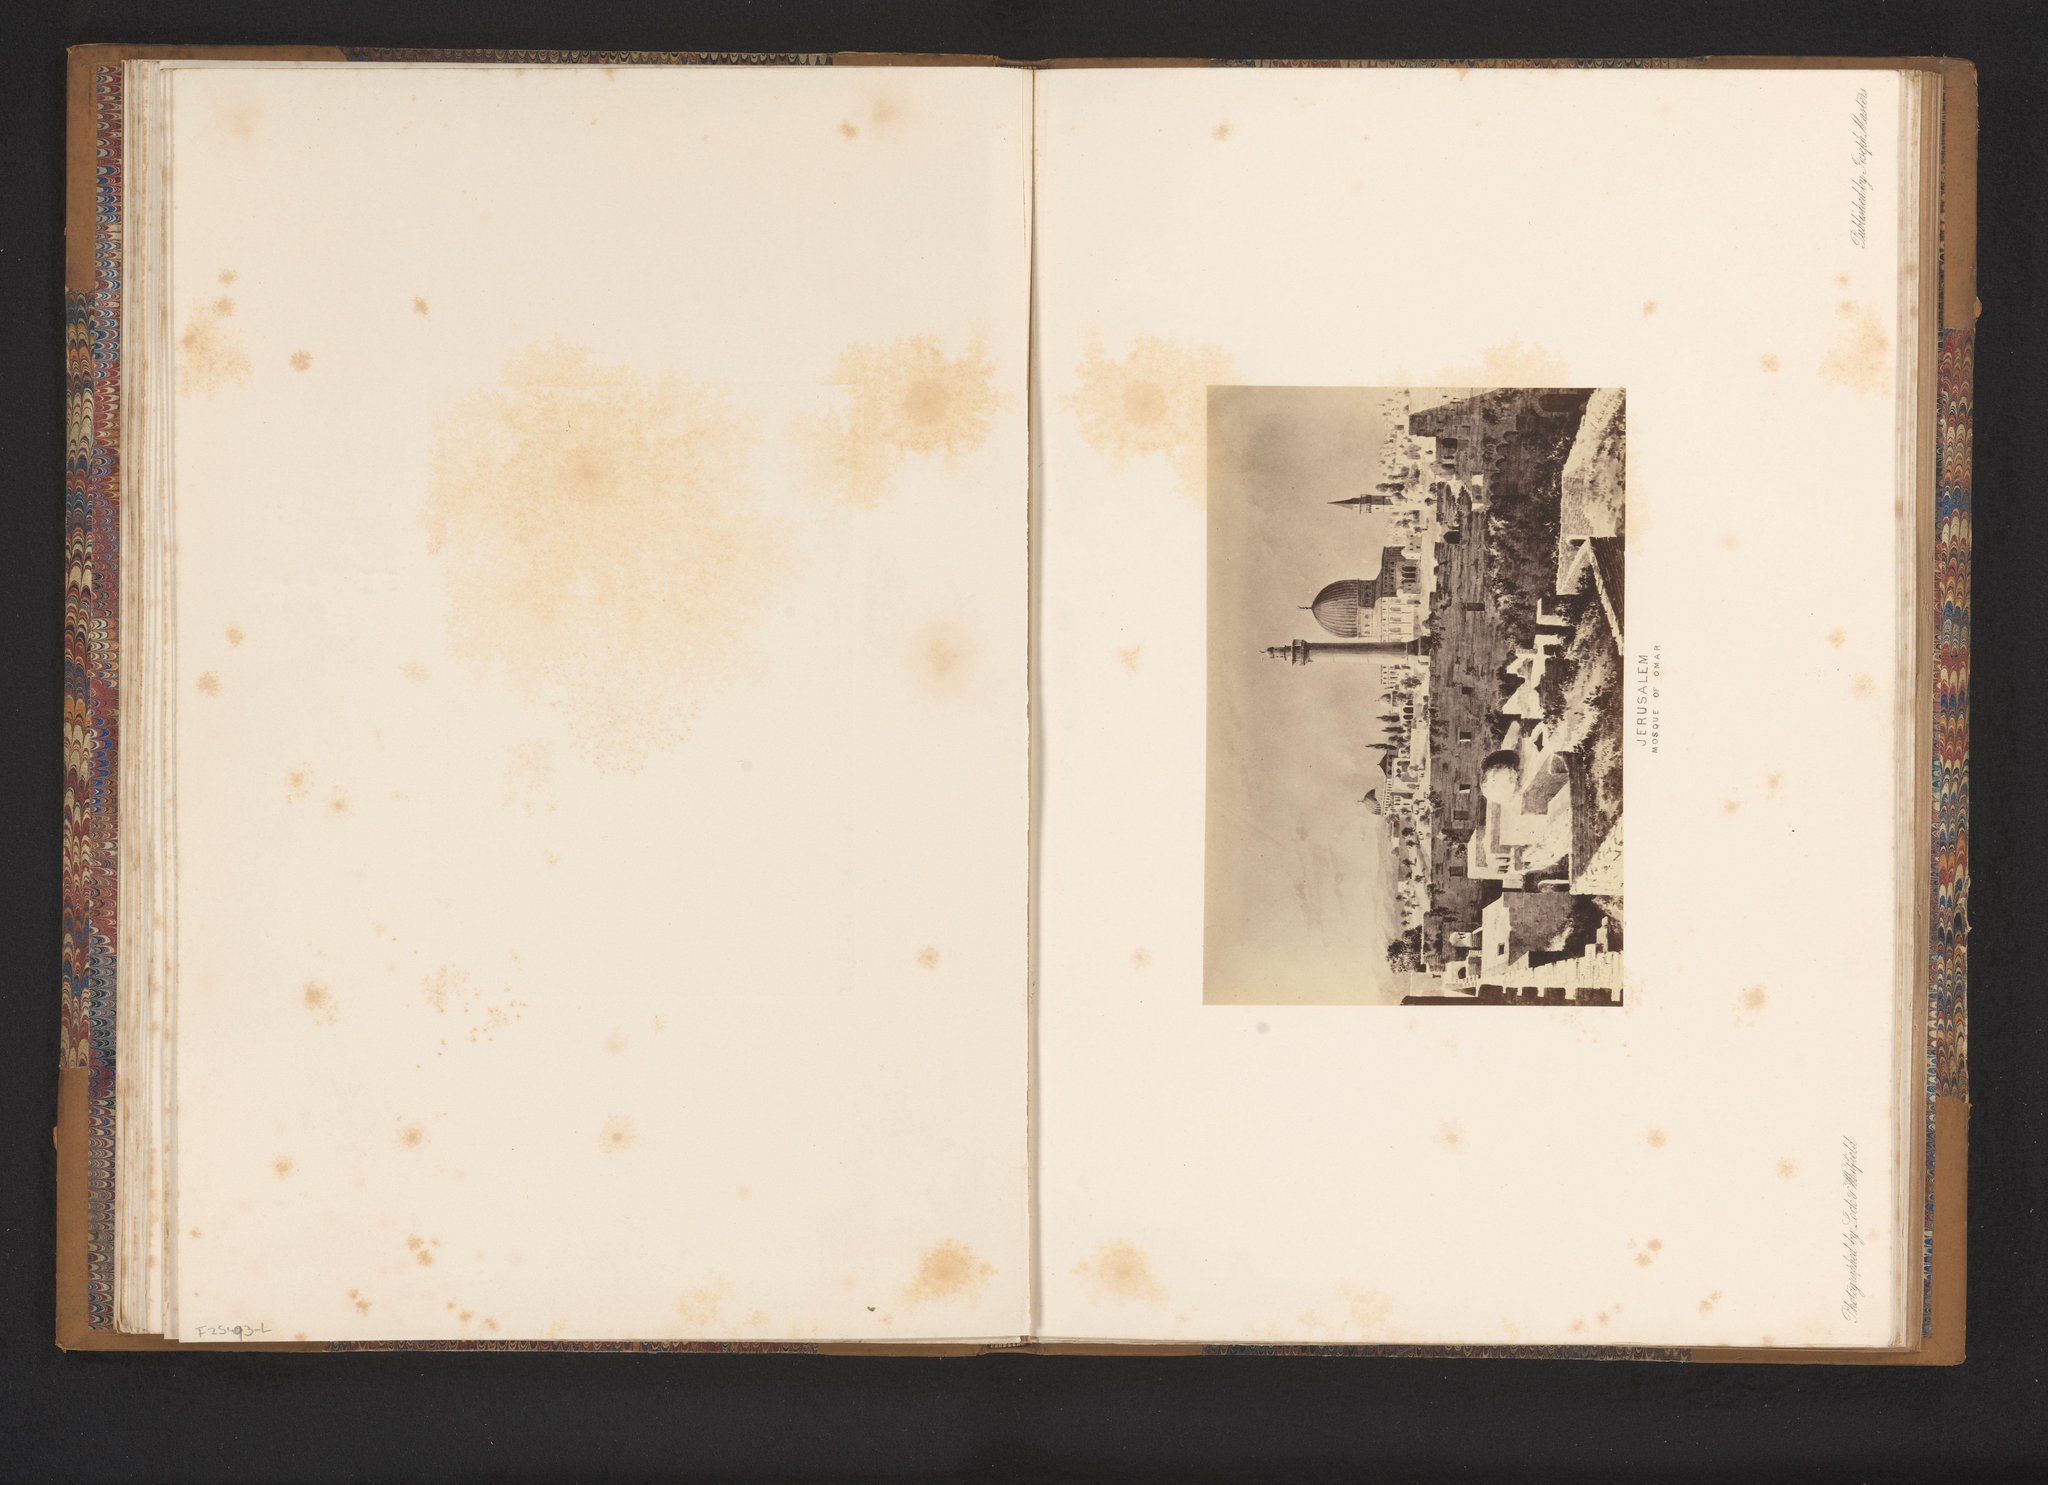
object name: reproduction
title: Jerusalem, Mosque of Omar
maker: conway mordaunt shipley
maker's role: draughtsman, painter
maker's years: 1824-1888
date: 1855-1865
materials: paper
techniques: albumen print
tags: temple, shrine ~ islam, mohammedanism